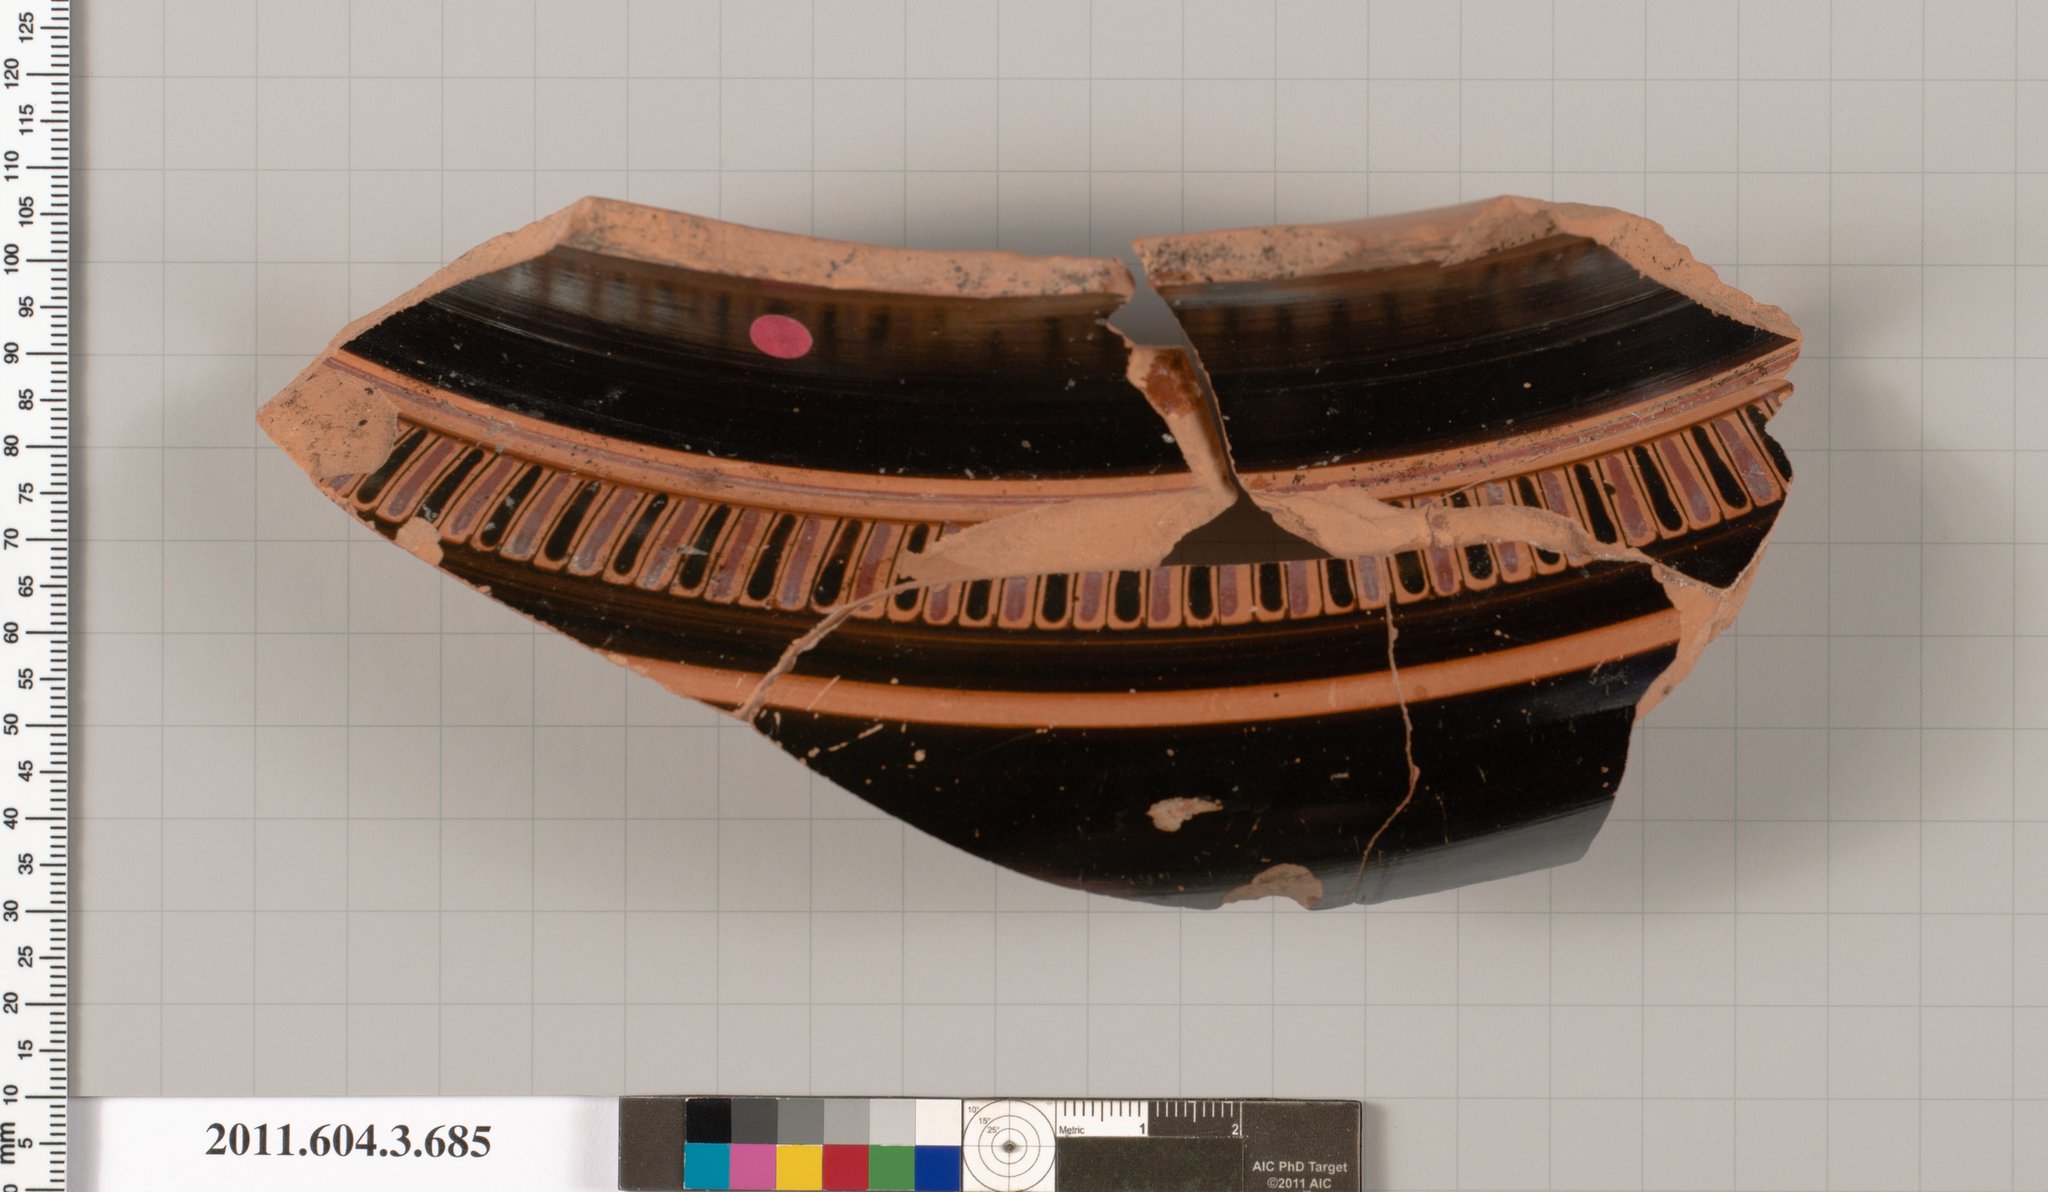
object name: stamnos fragment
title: Terracotta fragment of a stamnos (jar)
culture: greek, attic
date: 510-500 BCE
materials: terracotta